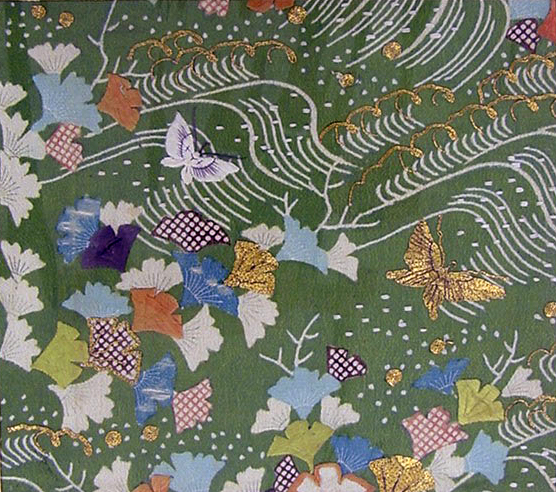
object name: piece from a kosode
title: Piece from a Kosode with Ginkgo Leaves, Waves, and Butterflies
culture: japanese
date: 1615-1868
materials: metal thread, silk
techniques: dyeing, embroidery, painting, weave, resist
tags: butterflies,leaves